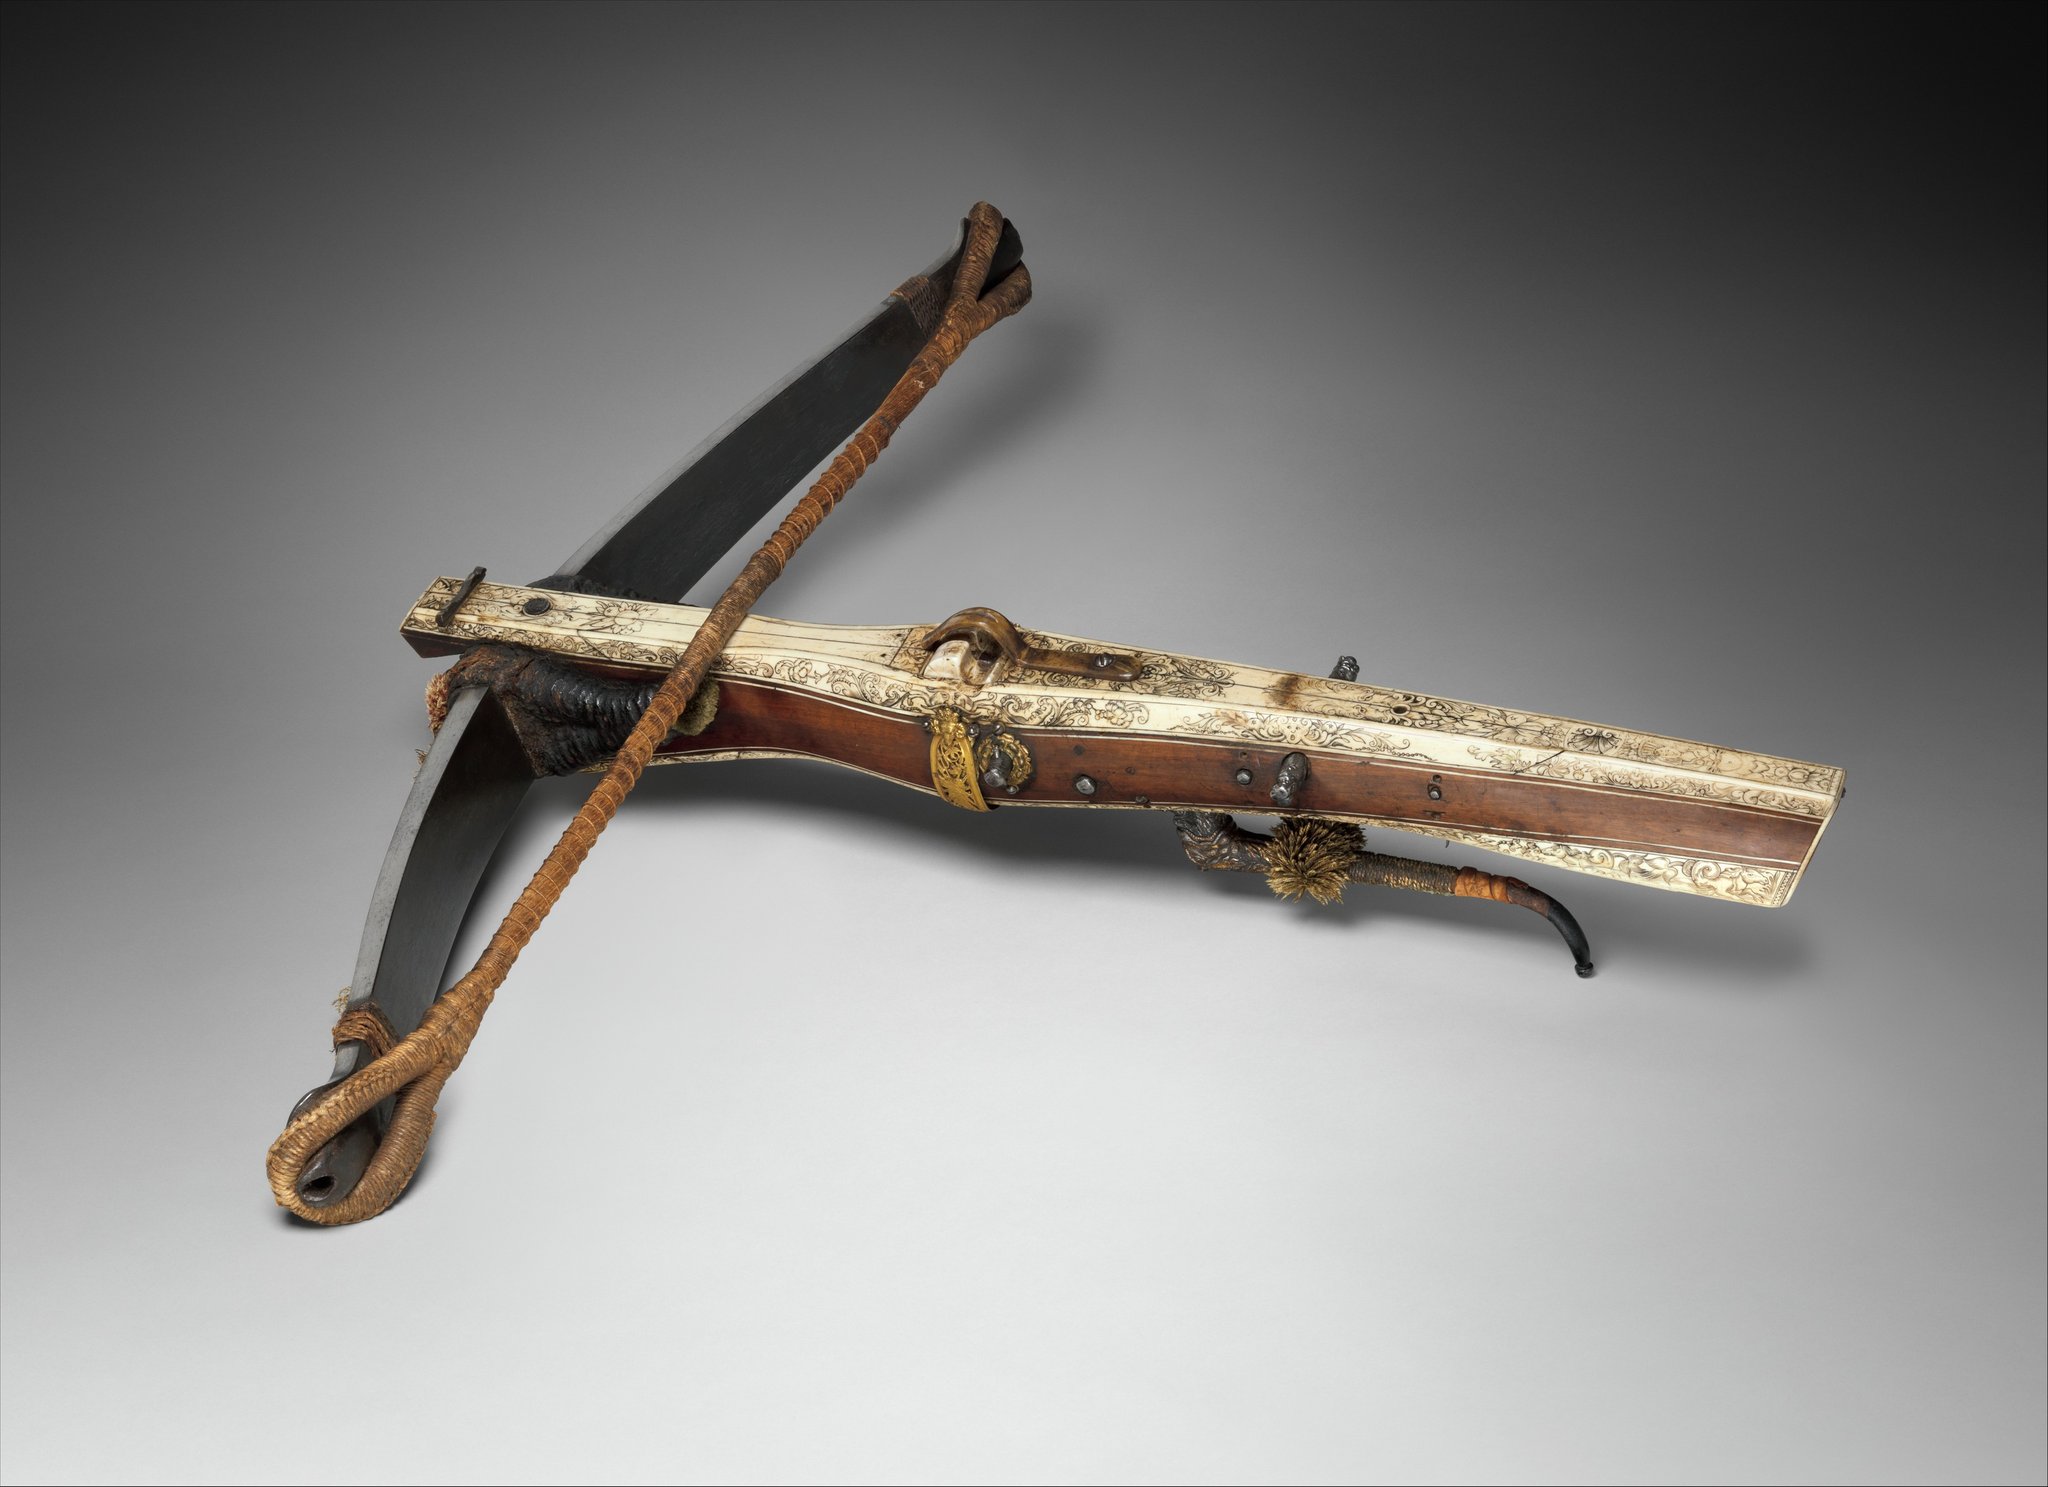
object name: crossbow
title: Large Crossbow (Ganze Rüstung) of Johann Georg, Baron von Rechenberg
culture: german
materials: copper alloy, gold, horn, ivory, leather, steel, wood, wool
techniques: veneering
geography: germany